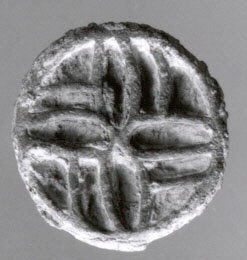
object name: stamp seal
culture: bactria-margiana archaeological complex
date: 2333-1668 BCE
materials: copper alloy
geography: bactria-margiana